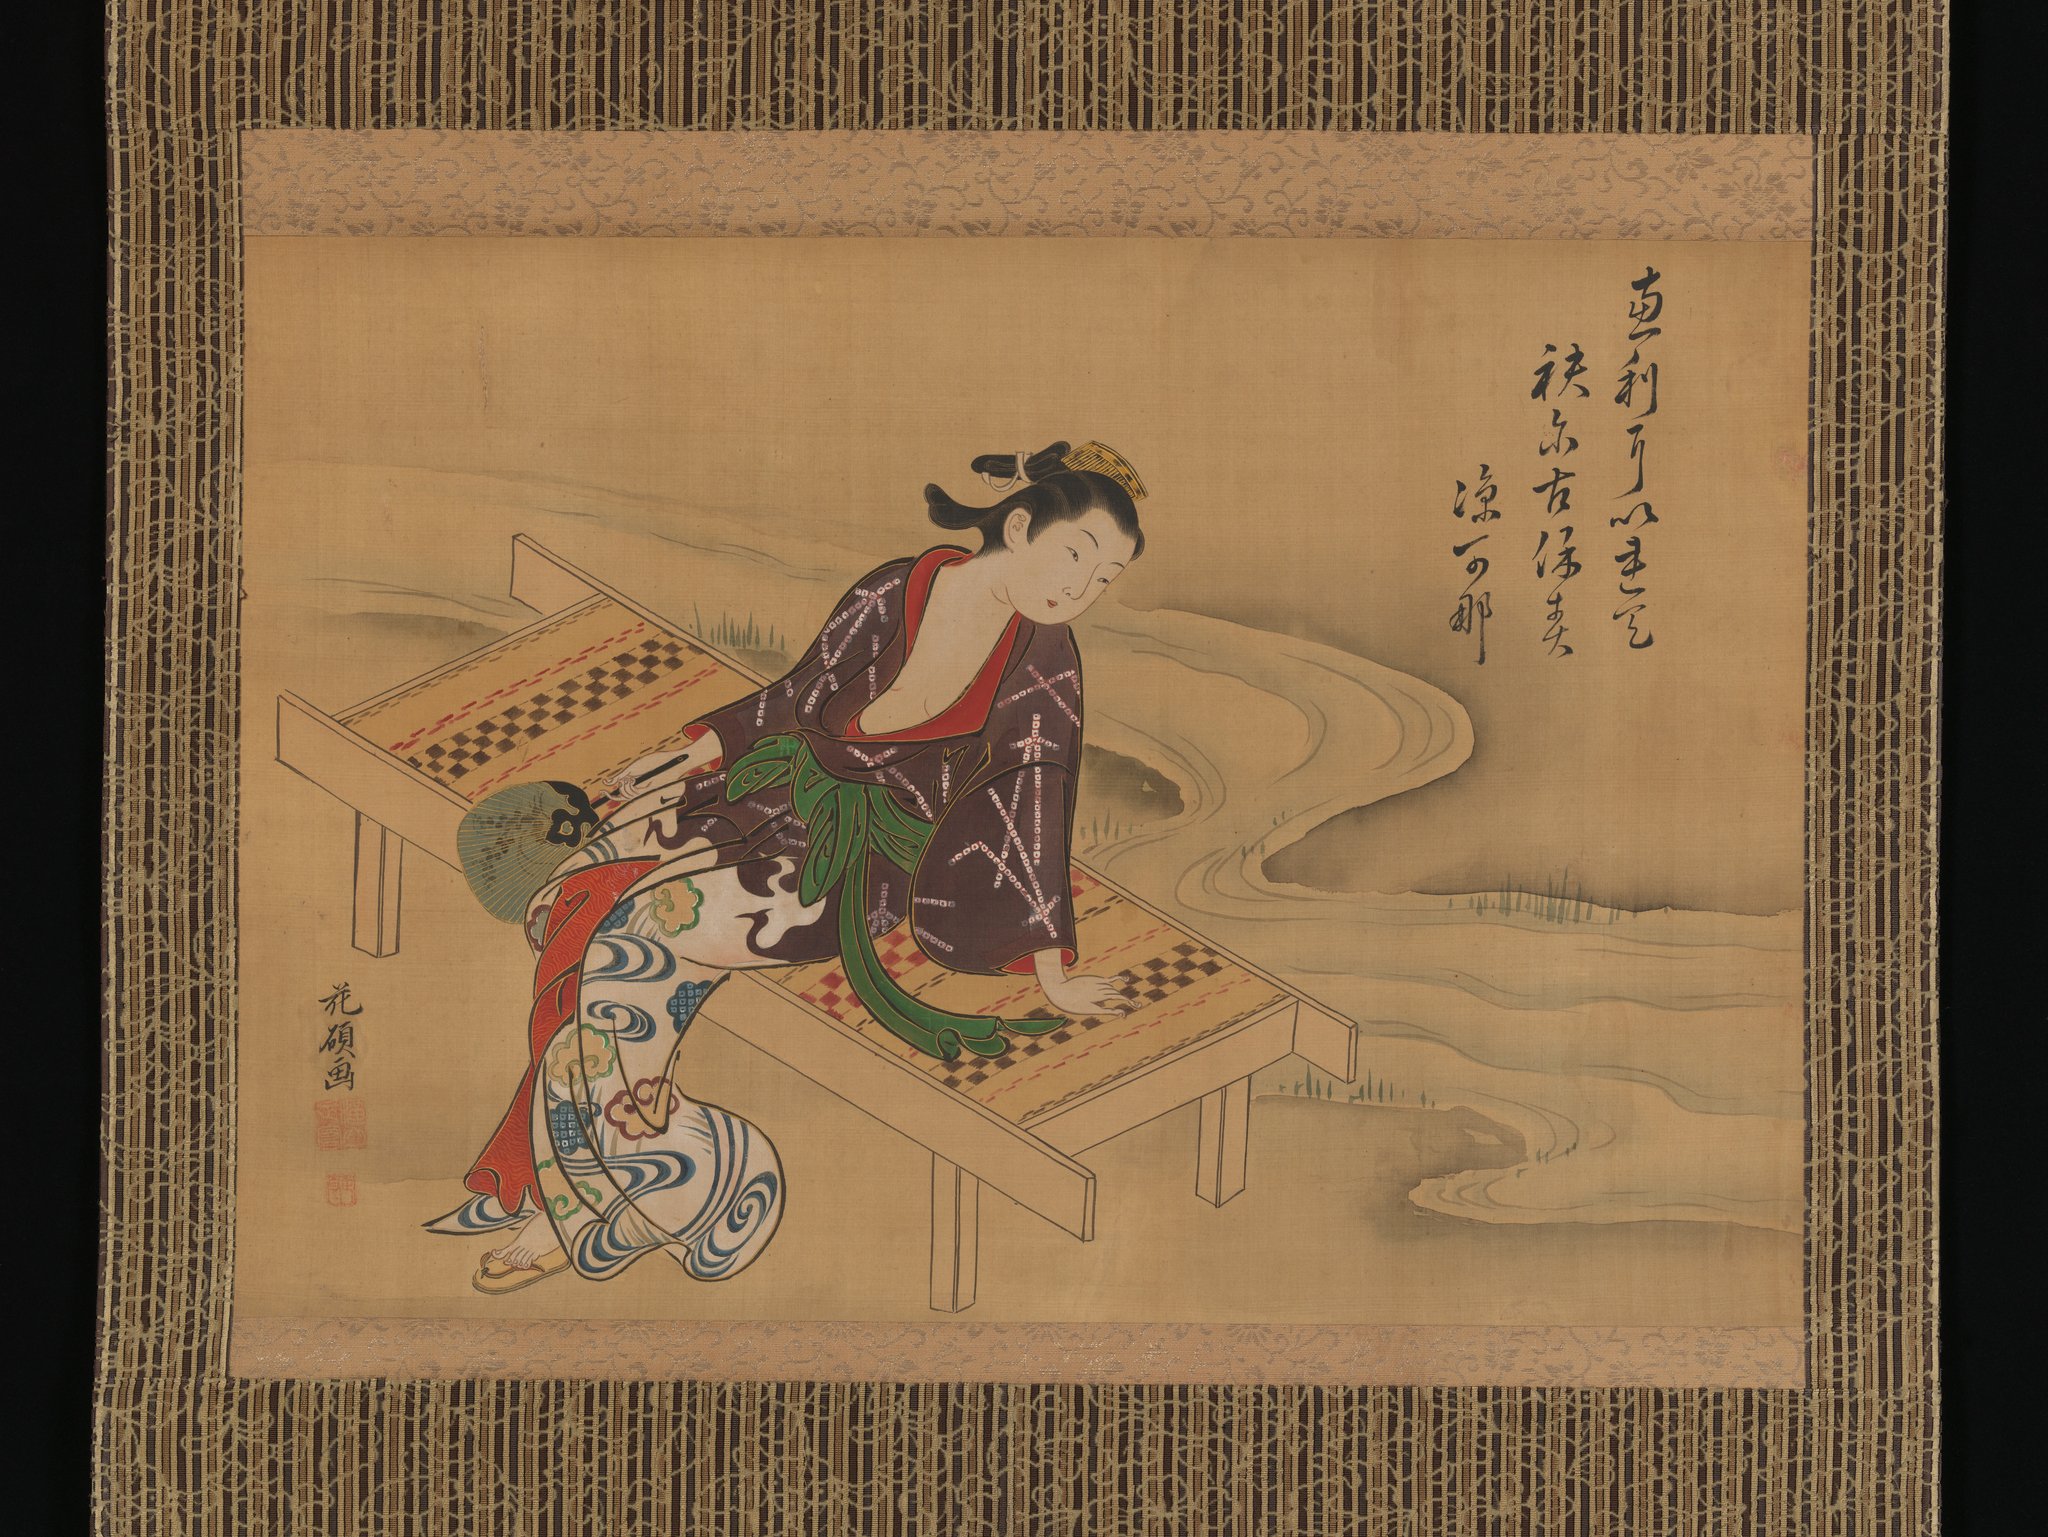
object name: hanging scroll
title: Enjoying the Cool Breeze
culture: japanese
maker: kaseki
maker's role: artist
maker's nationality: japanese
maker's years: 1700-1799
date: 1701-1733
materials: ink, silk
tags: fans,women,streams